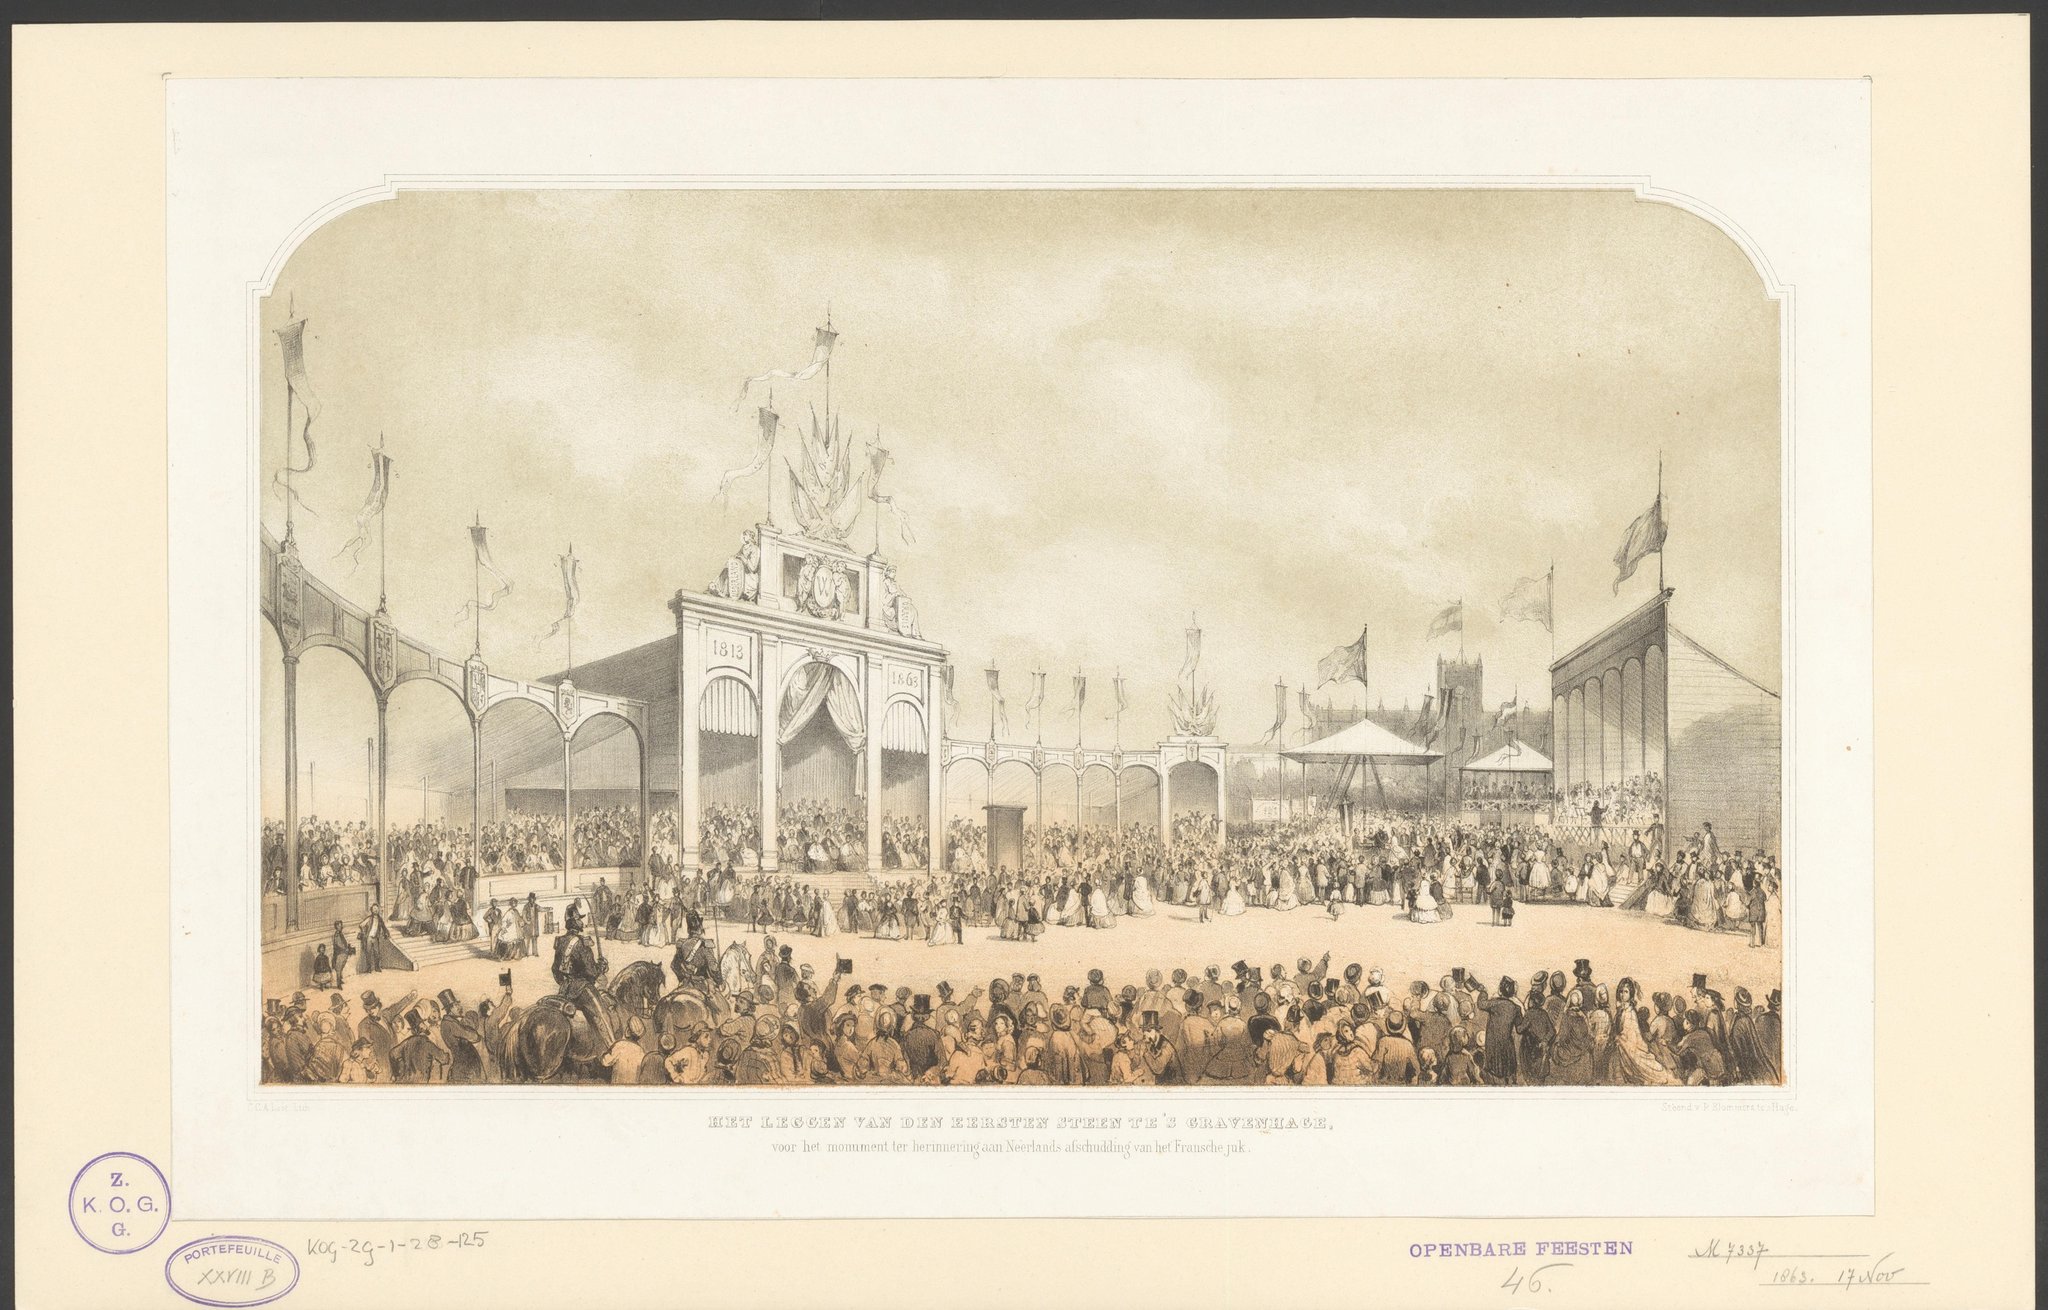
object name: print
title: Koning Willem III legt de eerste steen voor het monument ter herinnering aan de bevrijding van de Fransen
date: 1863-1865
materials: paper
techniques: iris print, lithograph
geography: the hague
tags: brussels, willem iii (koning der nederlanden), ceremonial laying of the foundations, laying the first stone, the hague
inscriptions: stamp, stamp, collector's mark: Lugt 1641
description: Een menigte heeft zich verzameld op een grote ronde tribune met daarop wapperende vaandels en de jaartallen 1813 en 1863. Links zit de Koninklijke familie en in het midden, onder een tent, legt Koning Willem III de steen. Rechts een tribune met een koor. Onderwerpsrubrieken binnen de Atlas Zeden en Gewoonten: Zeden en Gewoonten in Engeren Zin. Volksleven. Openbare feesten. Vorstelijke intochten, (Illuminaties, vuurwerken en dergelijke, openbare feesten).